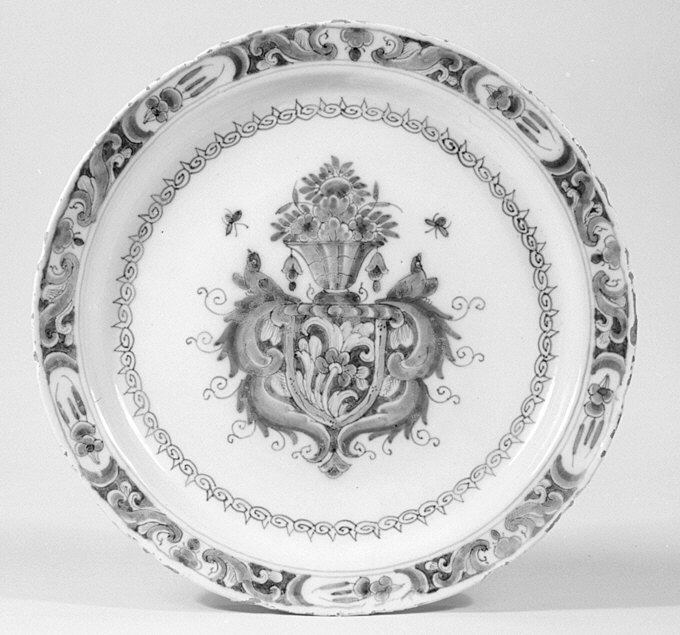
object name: dish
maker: de witte starre manufactory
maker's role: manufactory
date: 1705-1723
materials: earthenware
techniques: glazing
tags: flowers